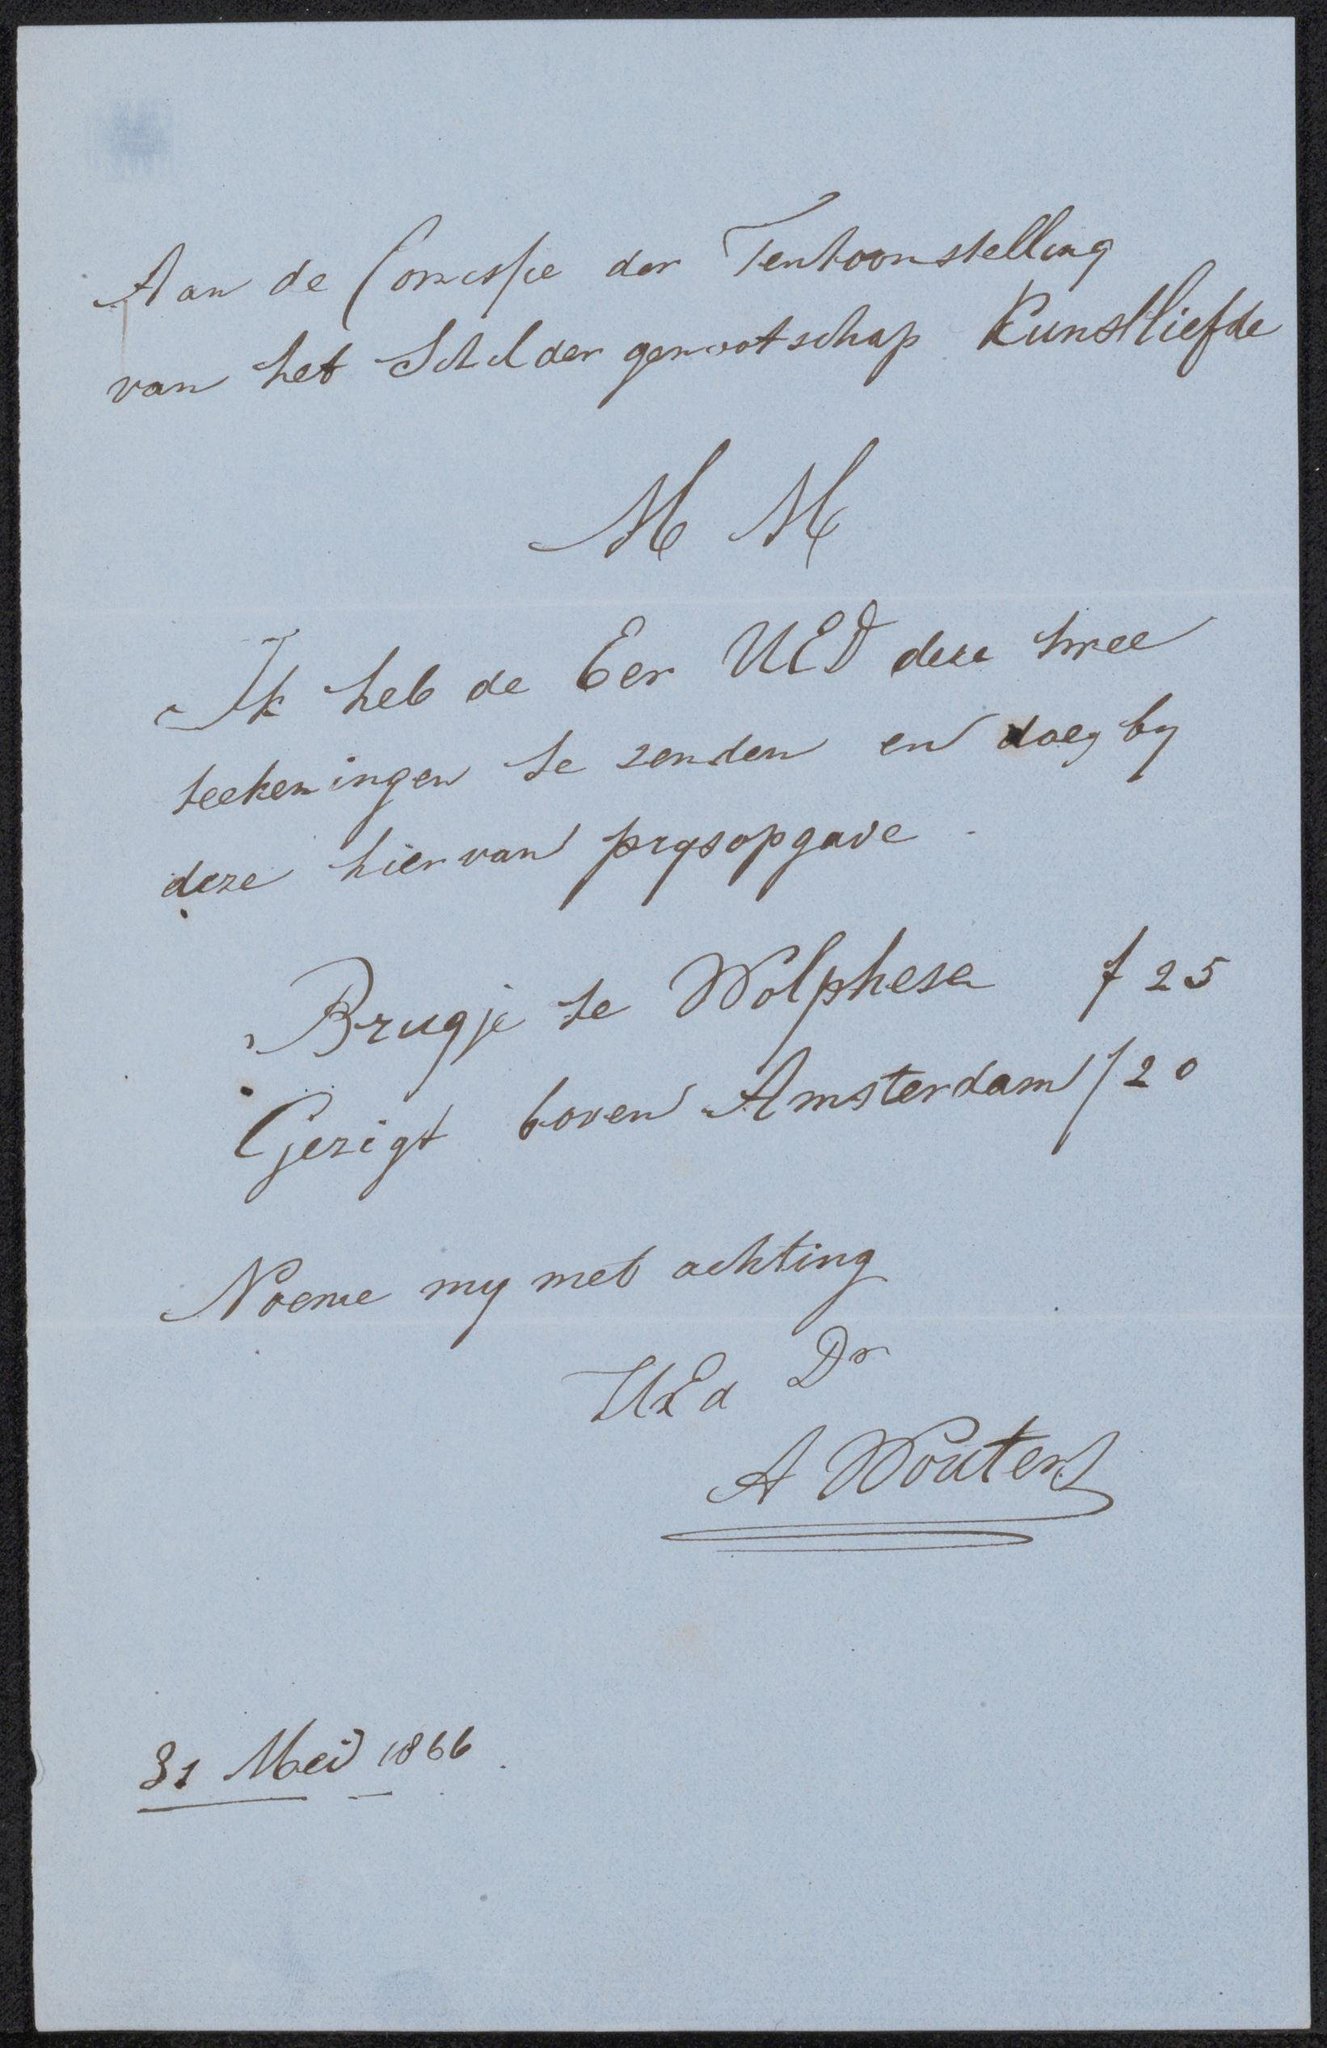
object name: letter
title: Brief aan de Commissie van de Tentoonstelling van Levende Meesters in Utrecht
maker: augustinus jacobus bernardus wouters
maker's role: print maker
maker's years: 1829-1904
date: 1866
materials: ink, paper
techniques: pen, writing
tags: drawing, money